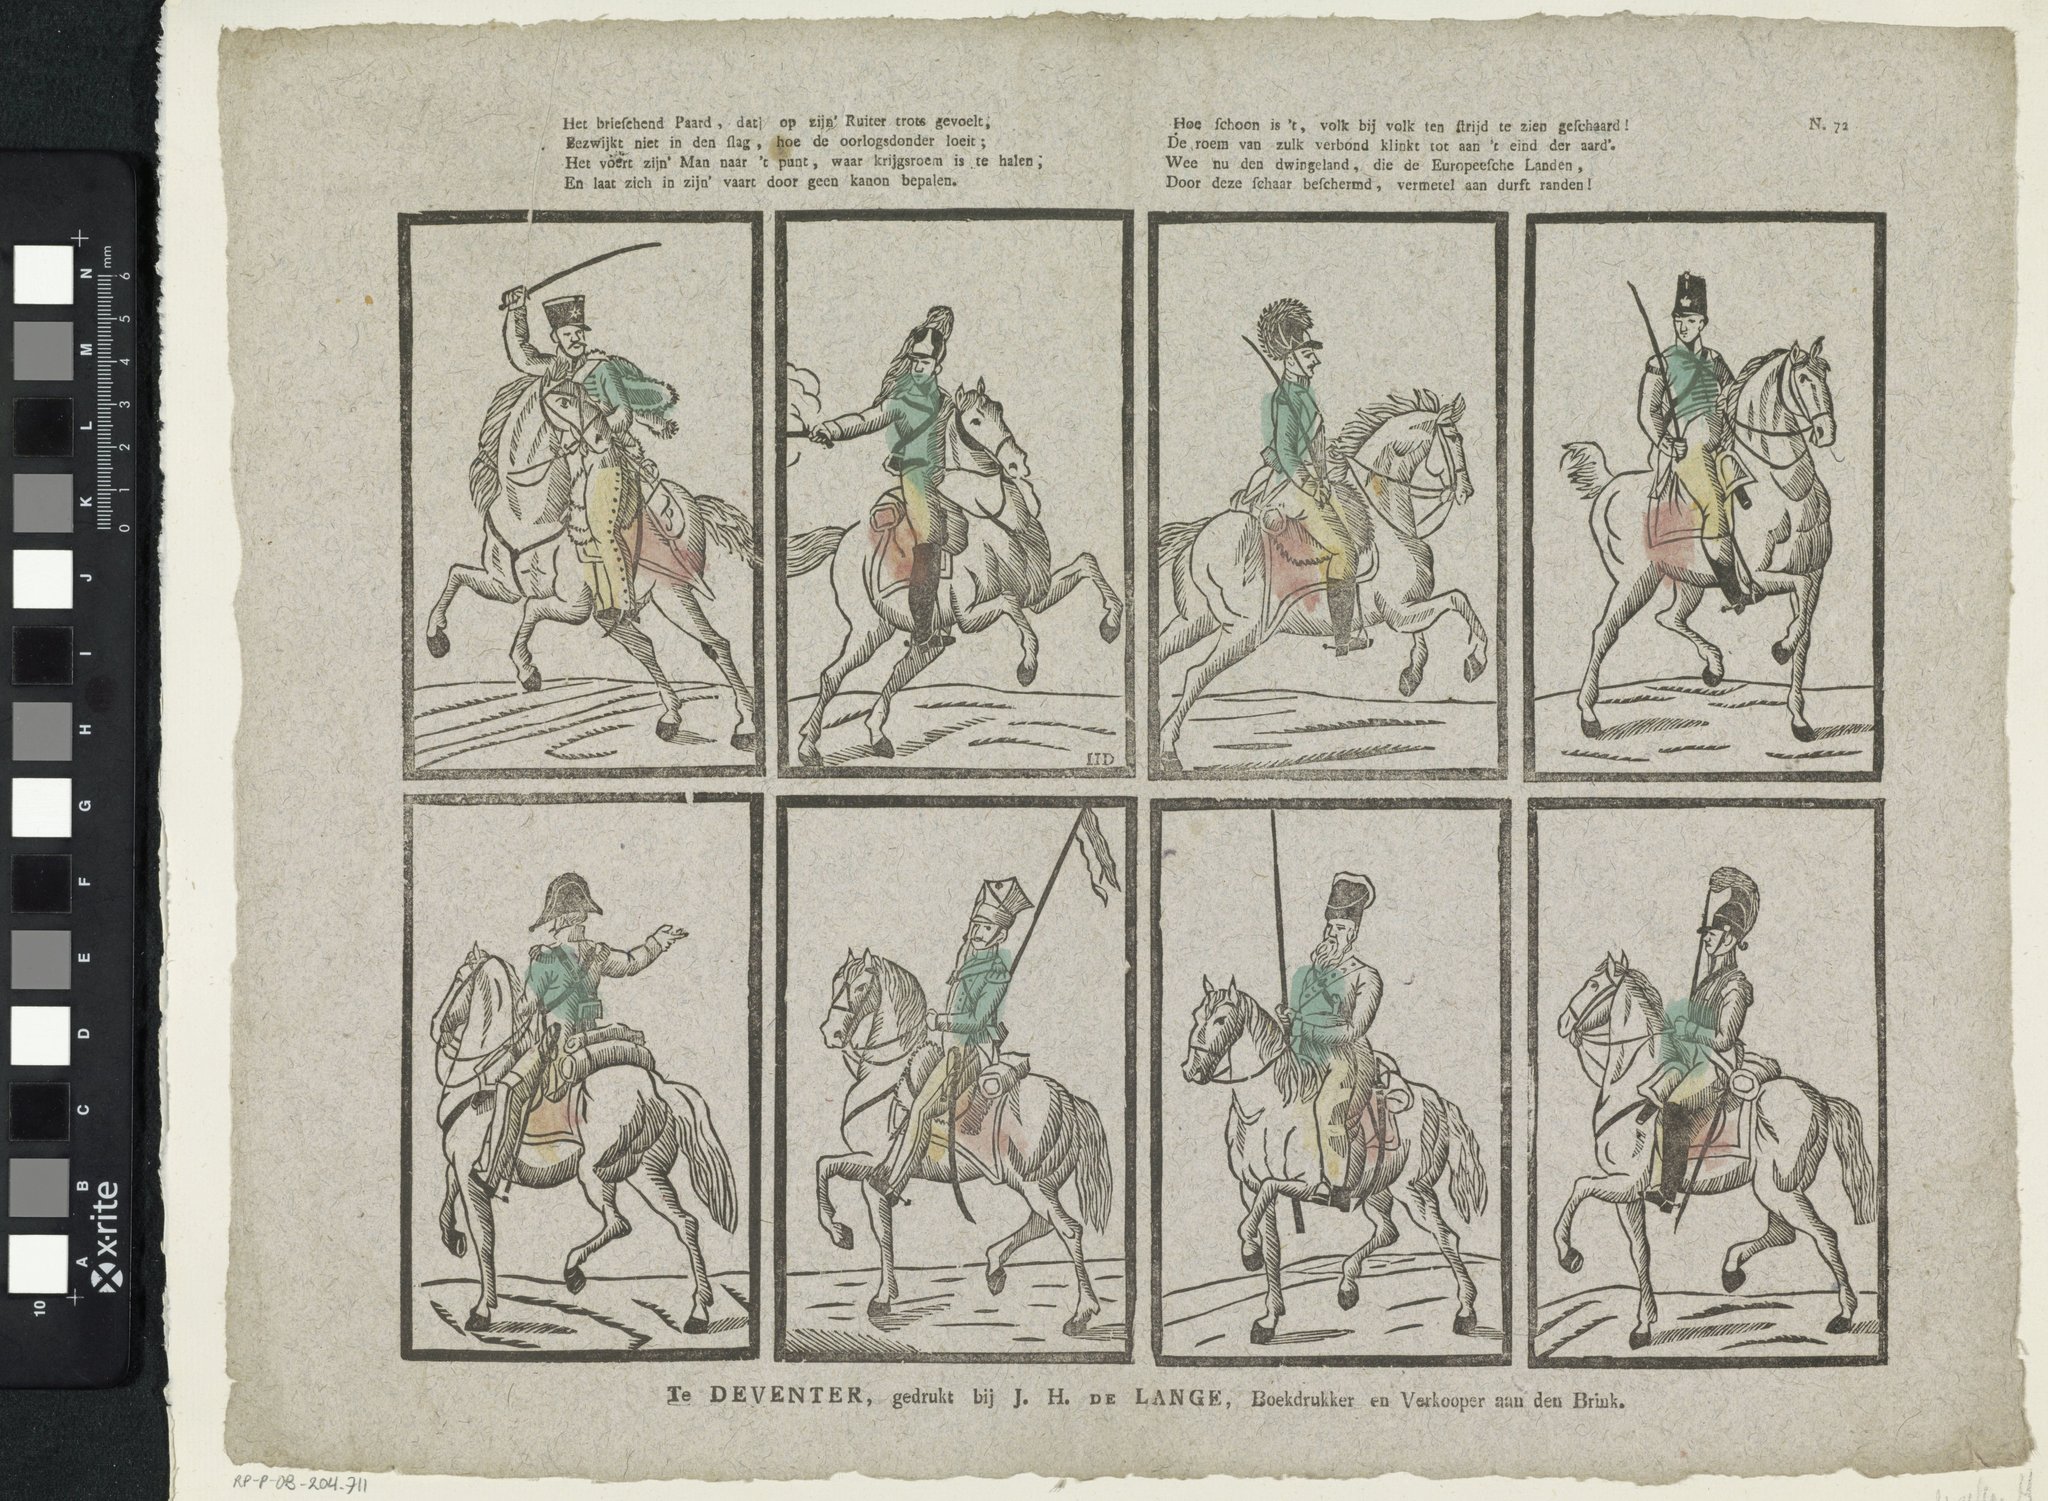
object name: popular print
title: Het brieschend paard, dat op zijn ruiter trots gevoelt, / Bezwijkt niet in den slag, hoe de oorlogsdonder loeit [(...)]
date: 1787-1822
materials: paper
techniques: colour, letterpress printing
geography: deventer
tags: warfare; military affairs (+ cavalry, horsemen), the soldier; the soldier's life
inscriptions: collector's mark: Lugt 2760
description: Blad met 8 voorstellingen van militairen te paard. Genummerd rechtsboven: N. 72.